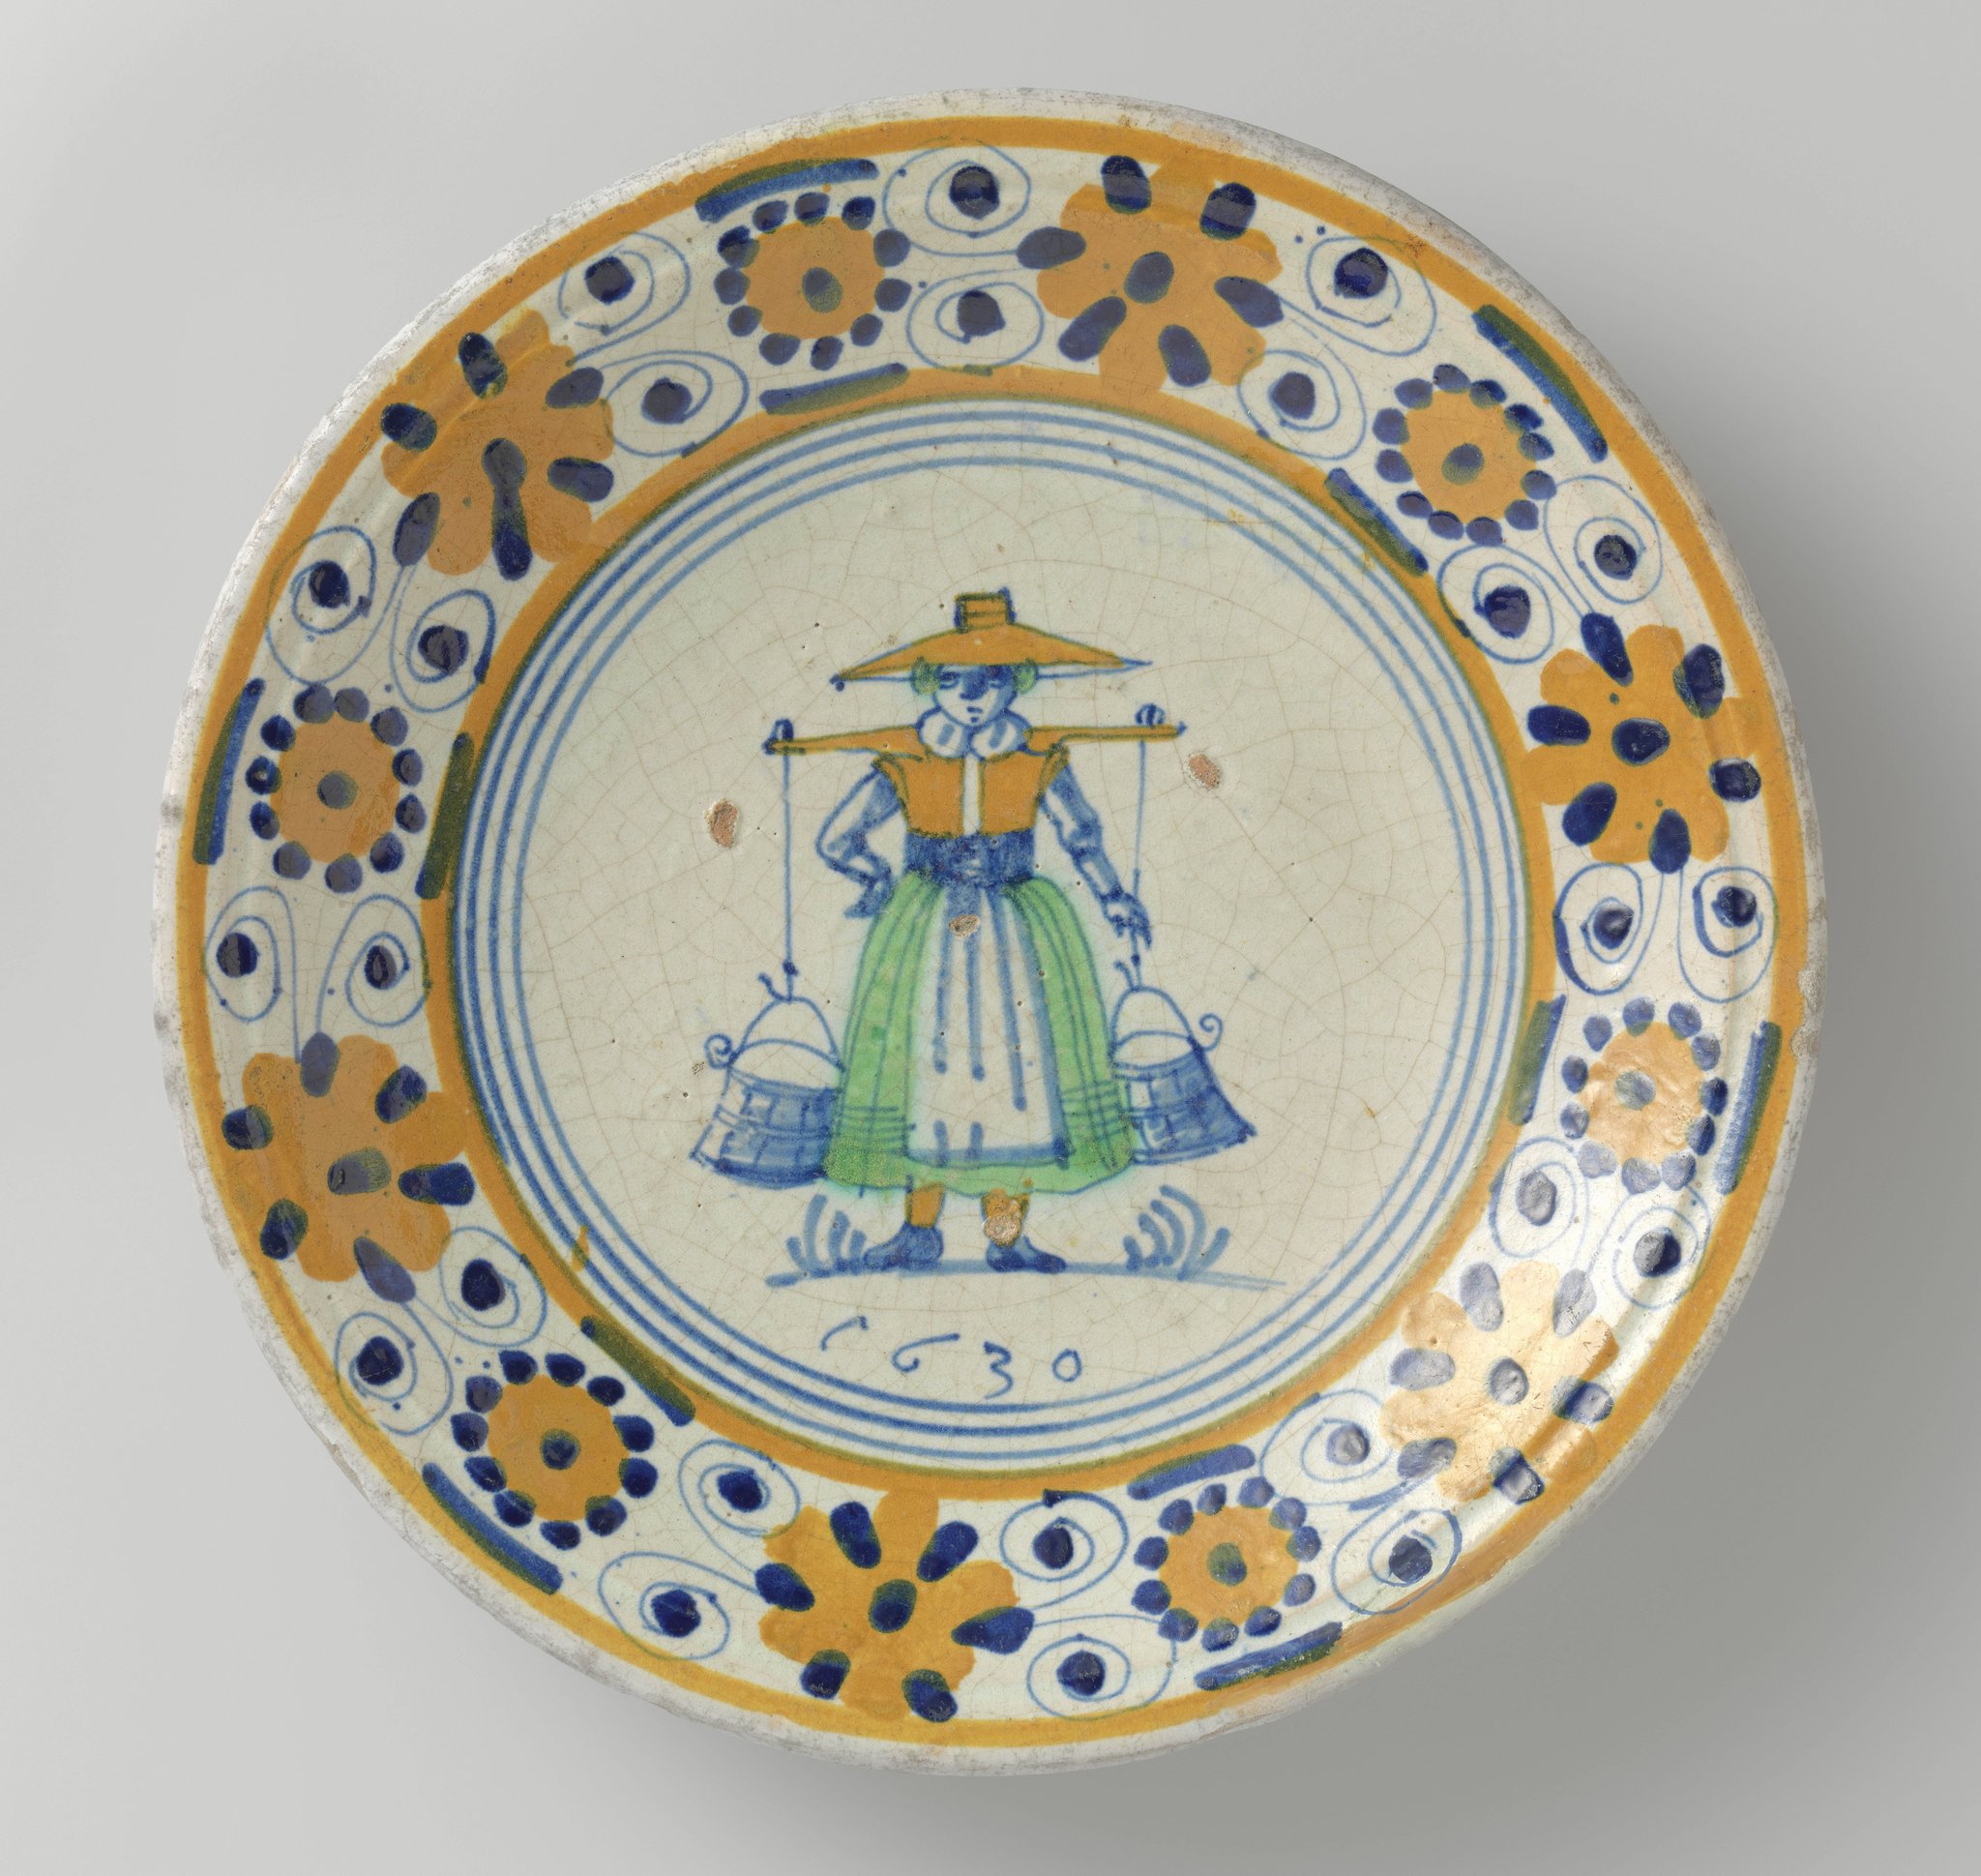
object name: plate dish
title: Plate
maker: Anonymous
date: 1630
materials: earthenware, glaze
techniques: maiolica, painted, polychromy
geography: netherlands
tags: carrying something with yoke, milkmaid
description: Rond bord van veelkleurig beschilderde majolica. Op het plat is een vrouw geschilderd met op haar schouders een juk waaraan twee emmers en het jaartal 1630. Op de rand zijn gestileerde bloemen en spiralen geschilderd.